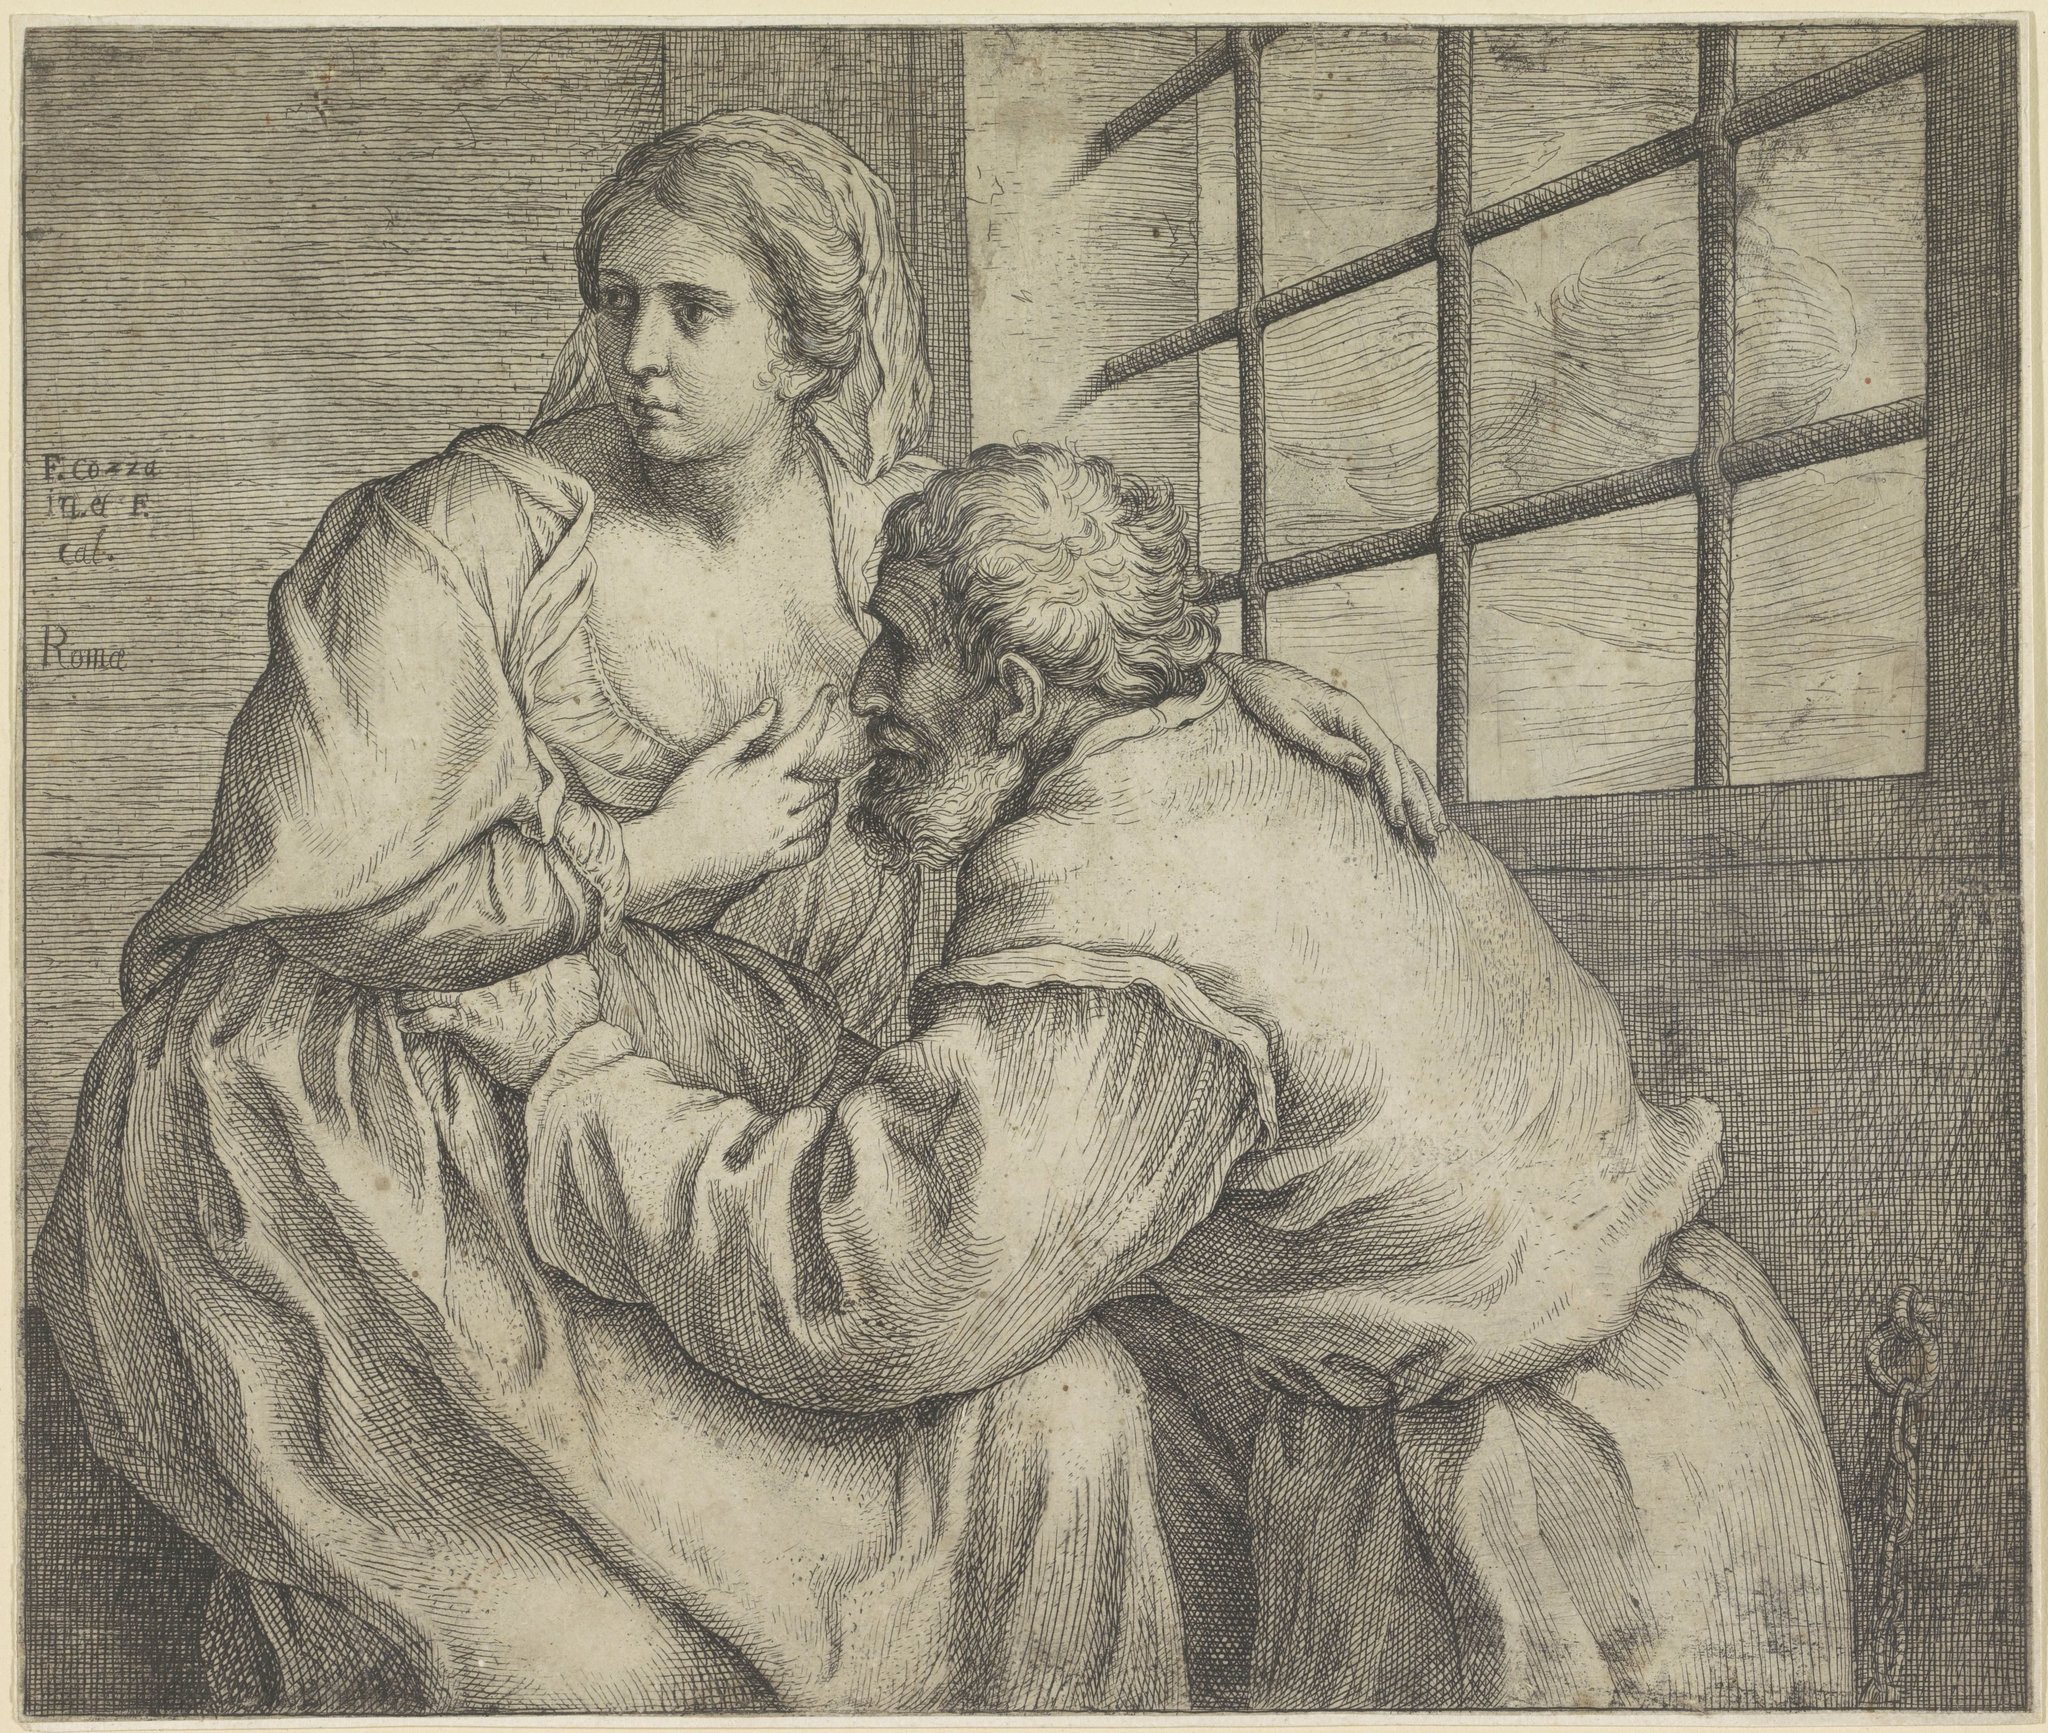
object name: print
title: Cimon en Pero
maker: francesco cozza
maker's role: print maker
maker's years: 1605-1682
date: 1615-1682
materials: paper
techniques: etching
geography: rome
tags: pero suckling cimon ('caritas romana')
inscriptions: collector's mark: Lugt 240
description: Pero zoogt haar vader Cimon in zijn cel.